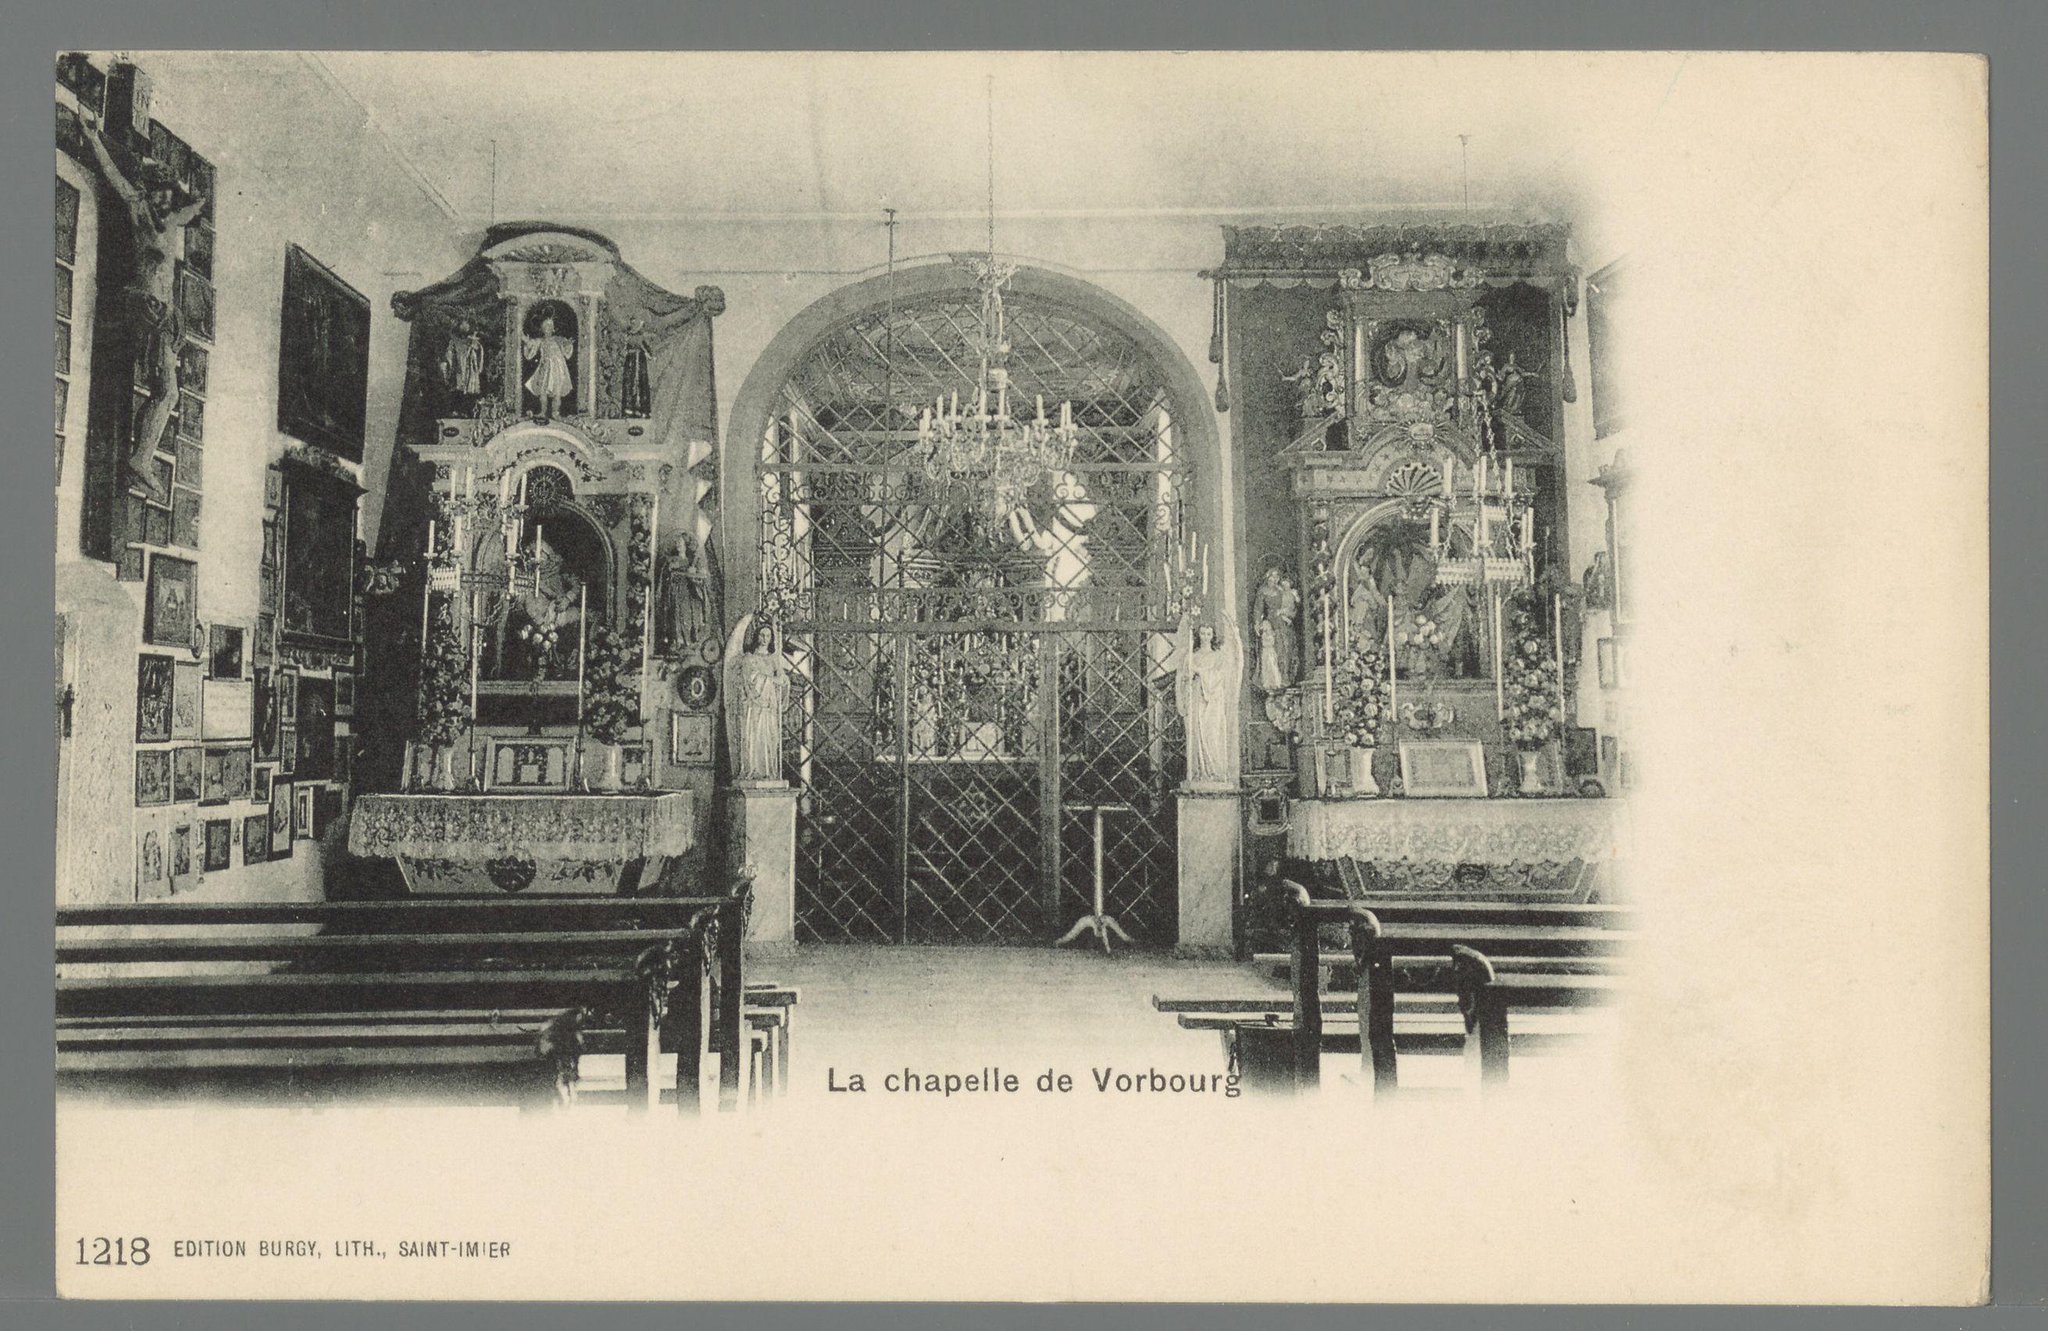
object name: photomechanical print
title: La chapelle de Vorbourg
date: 1890-1905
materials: cardboard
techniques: photograph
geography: saint-imier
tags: interior of church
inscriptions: stamp